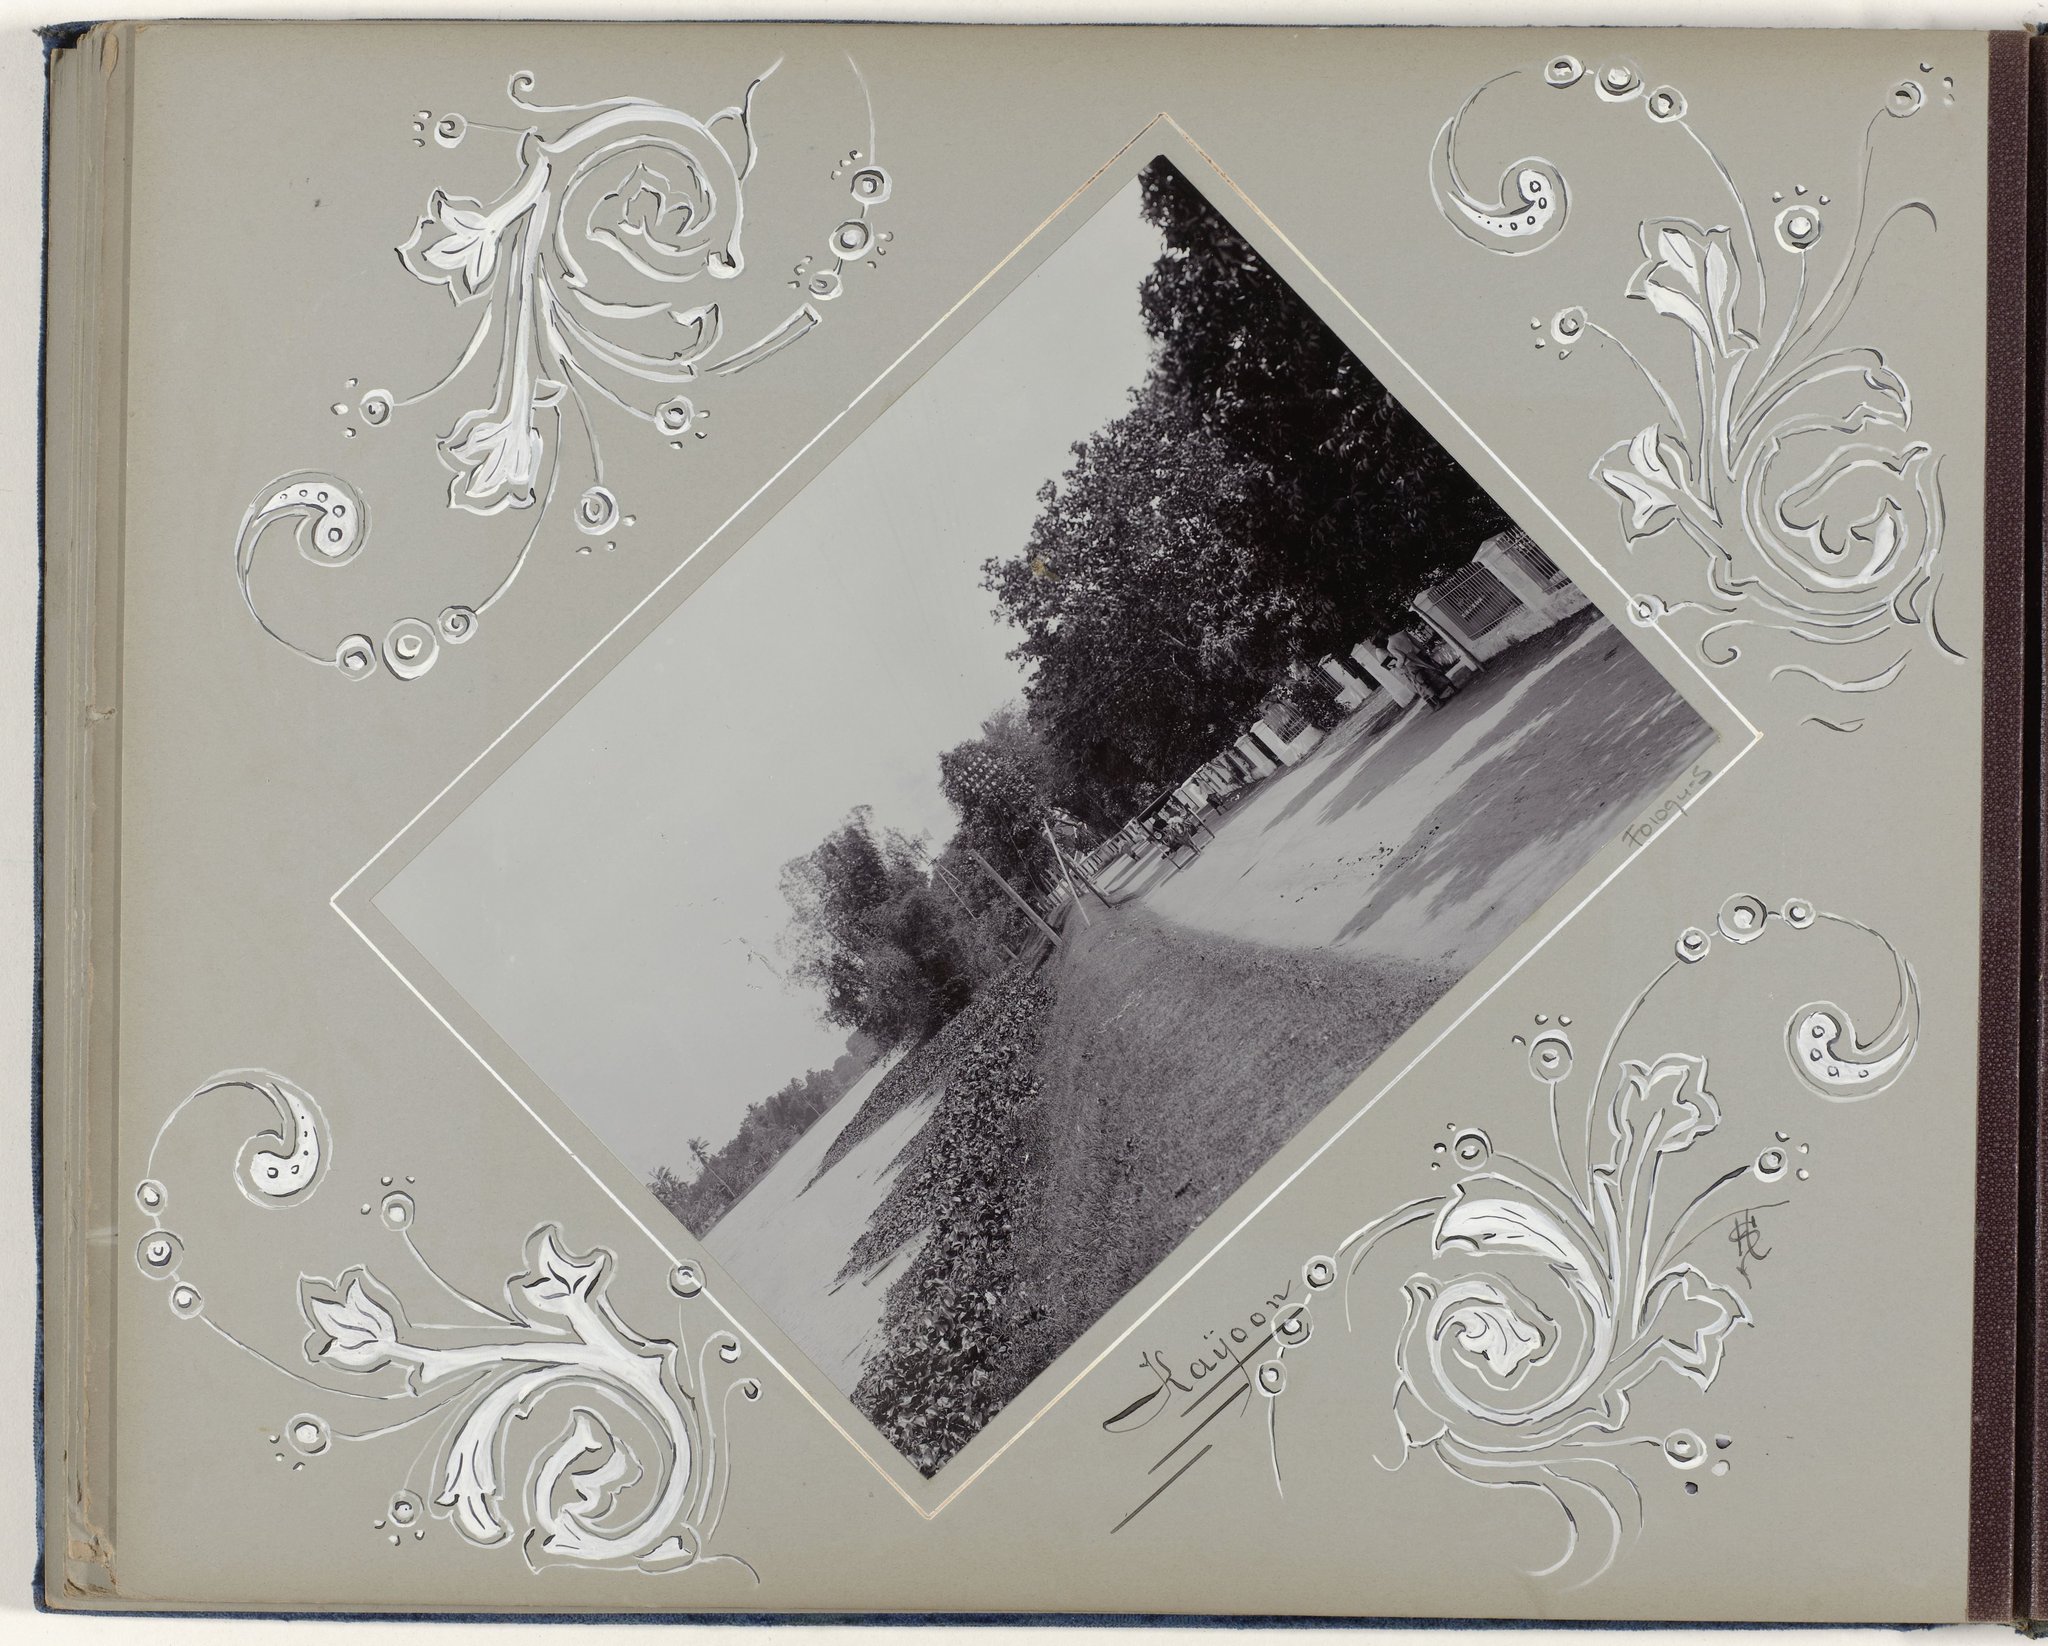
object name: photograph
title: Weg langs het water bij Kajoon in Soerabaja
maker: Anonymous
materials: cardboard, paper, photographic support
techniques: gelatin silver print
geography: surabaya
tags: two-wheeled, animal-drawn vehicle, river bank, street, surabaya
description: Onderdeel van Herinneringsalbum met foto's van Soerabaja.